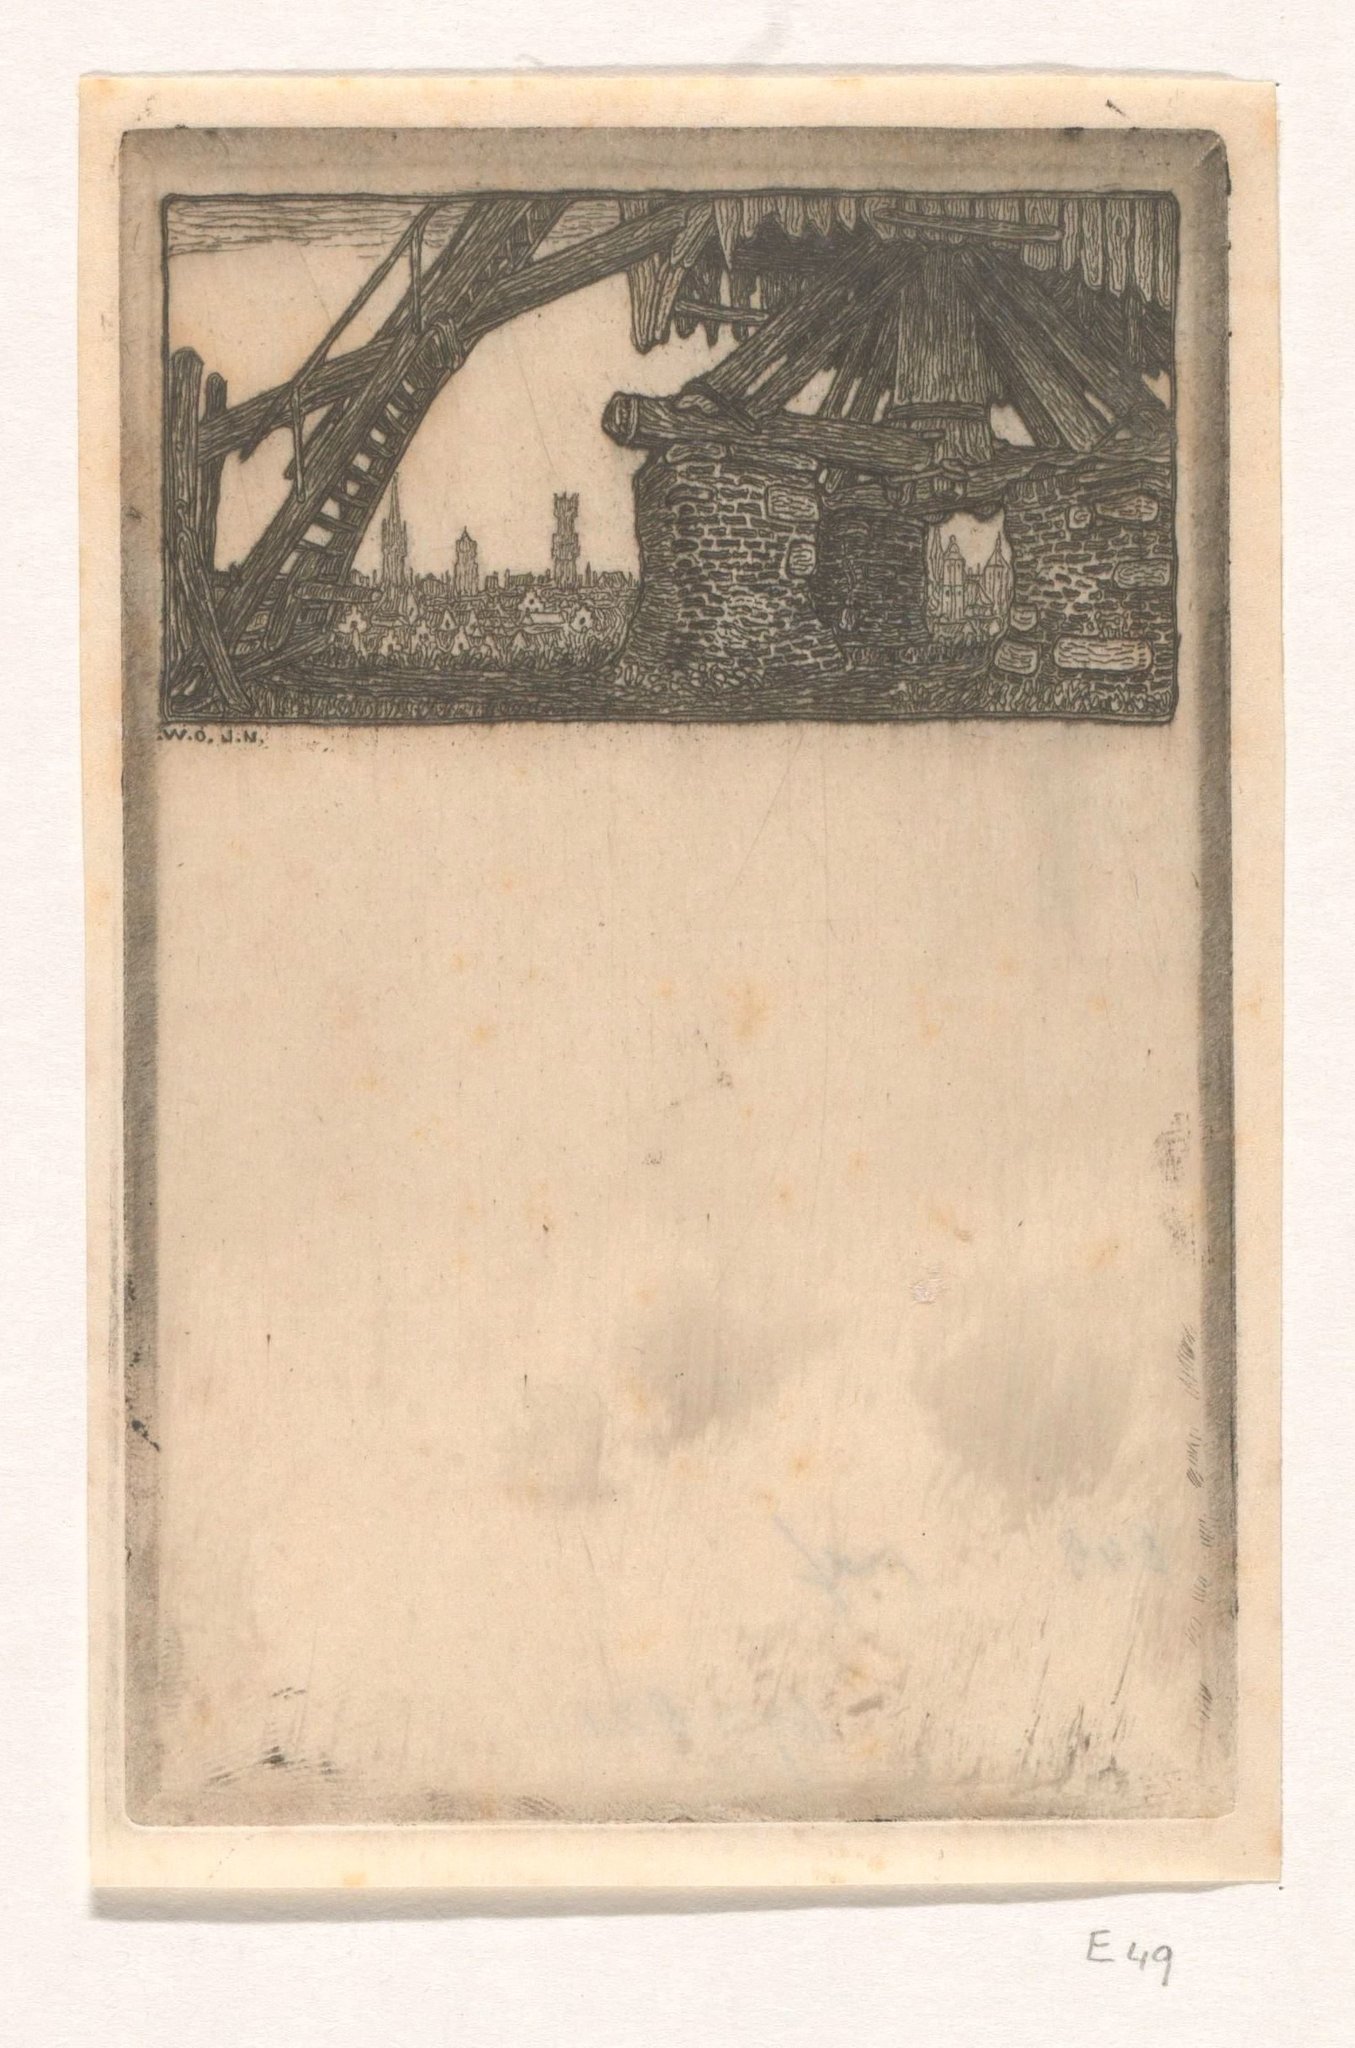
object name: print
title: Gezicht op de Keizersgracht en de Westerkerk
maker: Anonymous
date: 1710-1711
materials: paper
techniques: engraving, etching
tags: city-view, and landscape with man-made constructions, canals, waters (in city)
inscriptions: collector's mark: Lugt 2233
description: Prent verschenen in: 100 Afbeeldinge der voornaamste gebouwen van Amsterdam. Amsterdam: Pieter Schenk (I), [1710-1711]. En in: 100 Afbeeldinge der voornaamste gebouwen van Amsterdam. Amsterdam: Barent Greve, [1757-1766].* *In de tweede uitgave, uitgegeven door Barent Greve, is alleen de titelprent aangepast. De overige prenten zijn onveranderd gebleven.